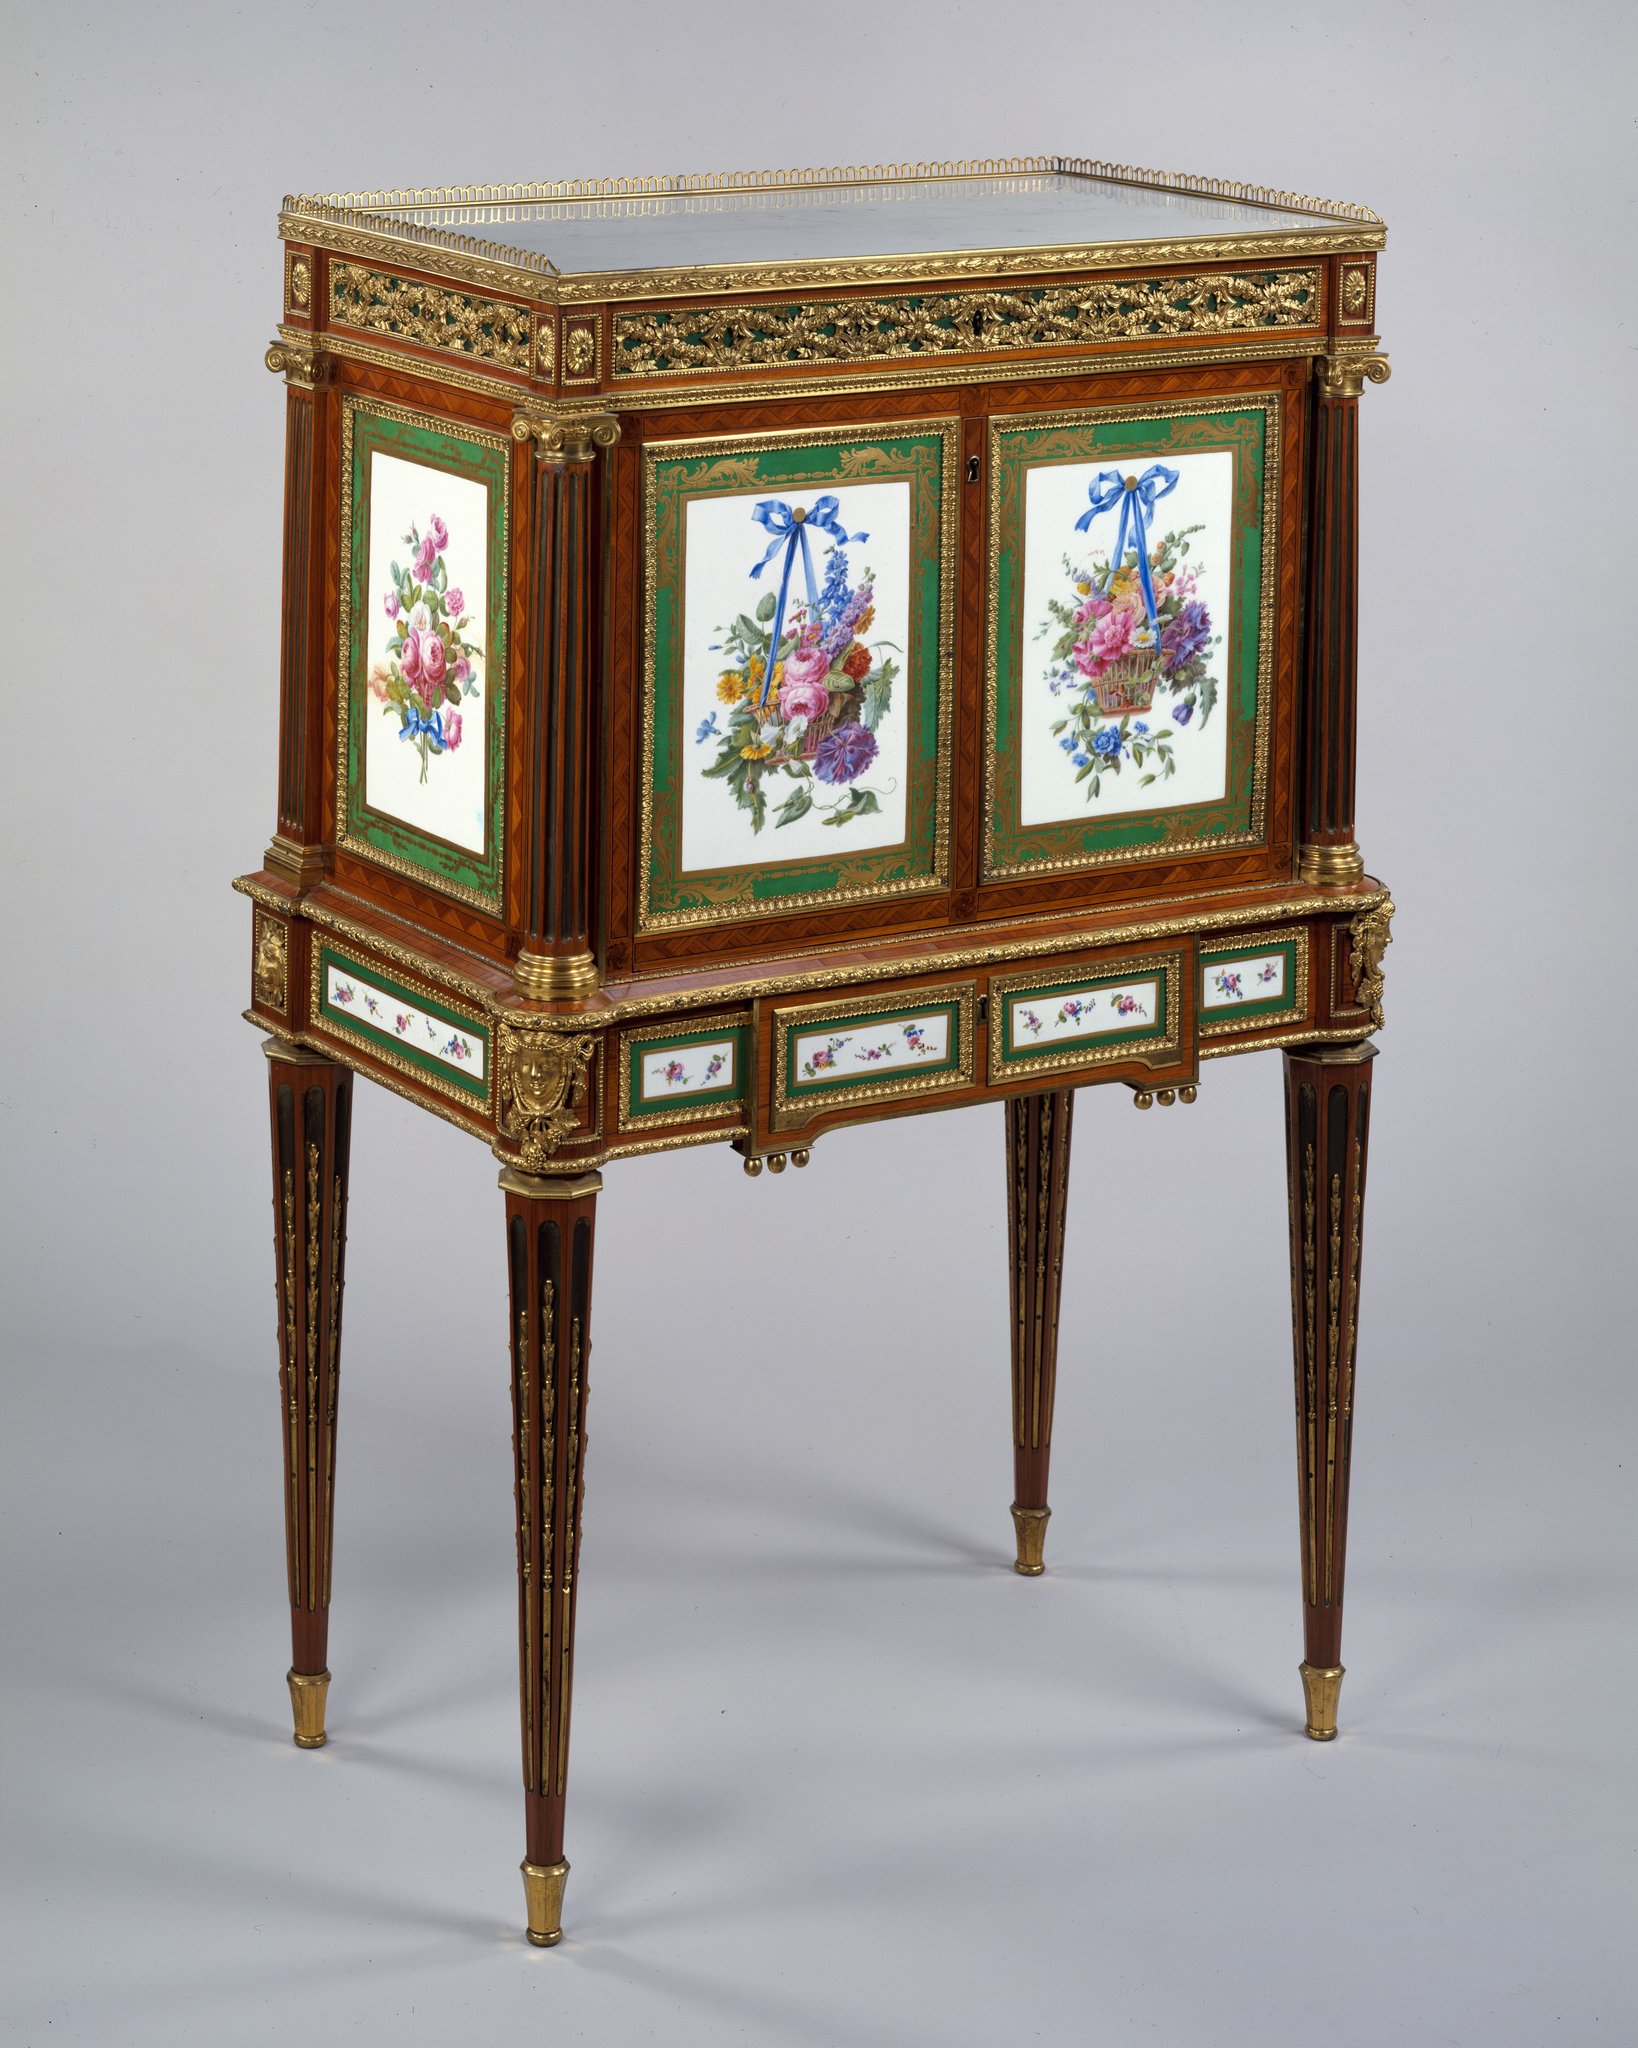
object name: secretary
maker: martin carlin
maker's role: artist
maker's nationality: french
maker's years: 1725-1785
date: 1781-1785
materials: brass, gilt bronze, marble, metal, wood, soft paste porcelain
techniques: veneering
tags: flowers